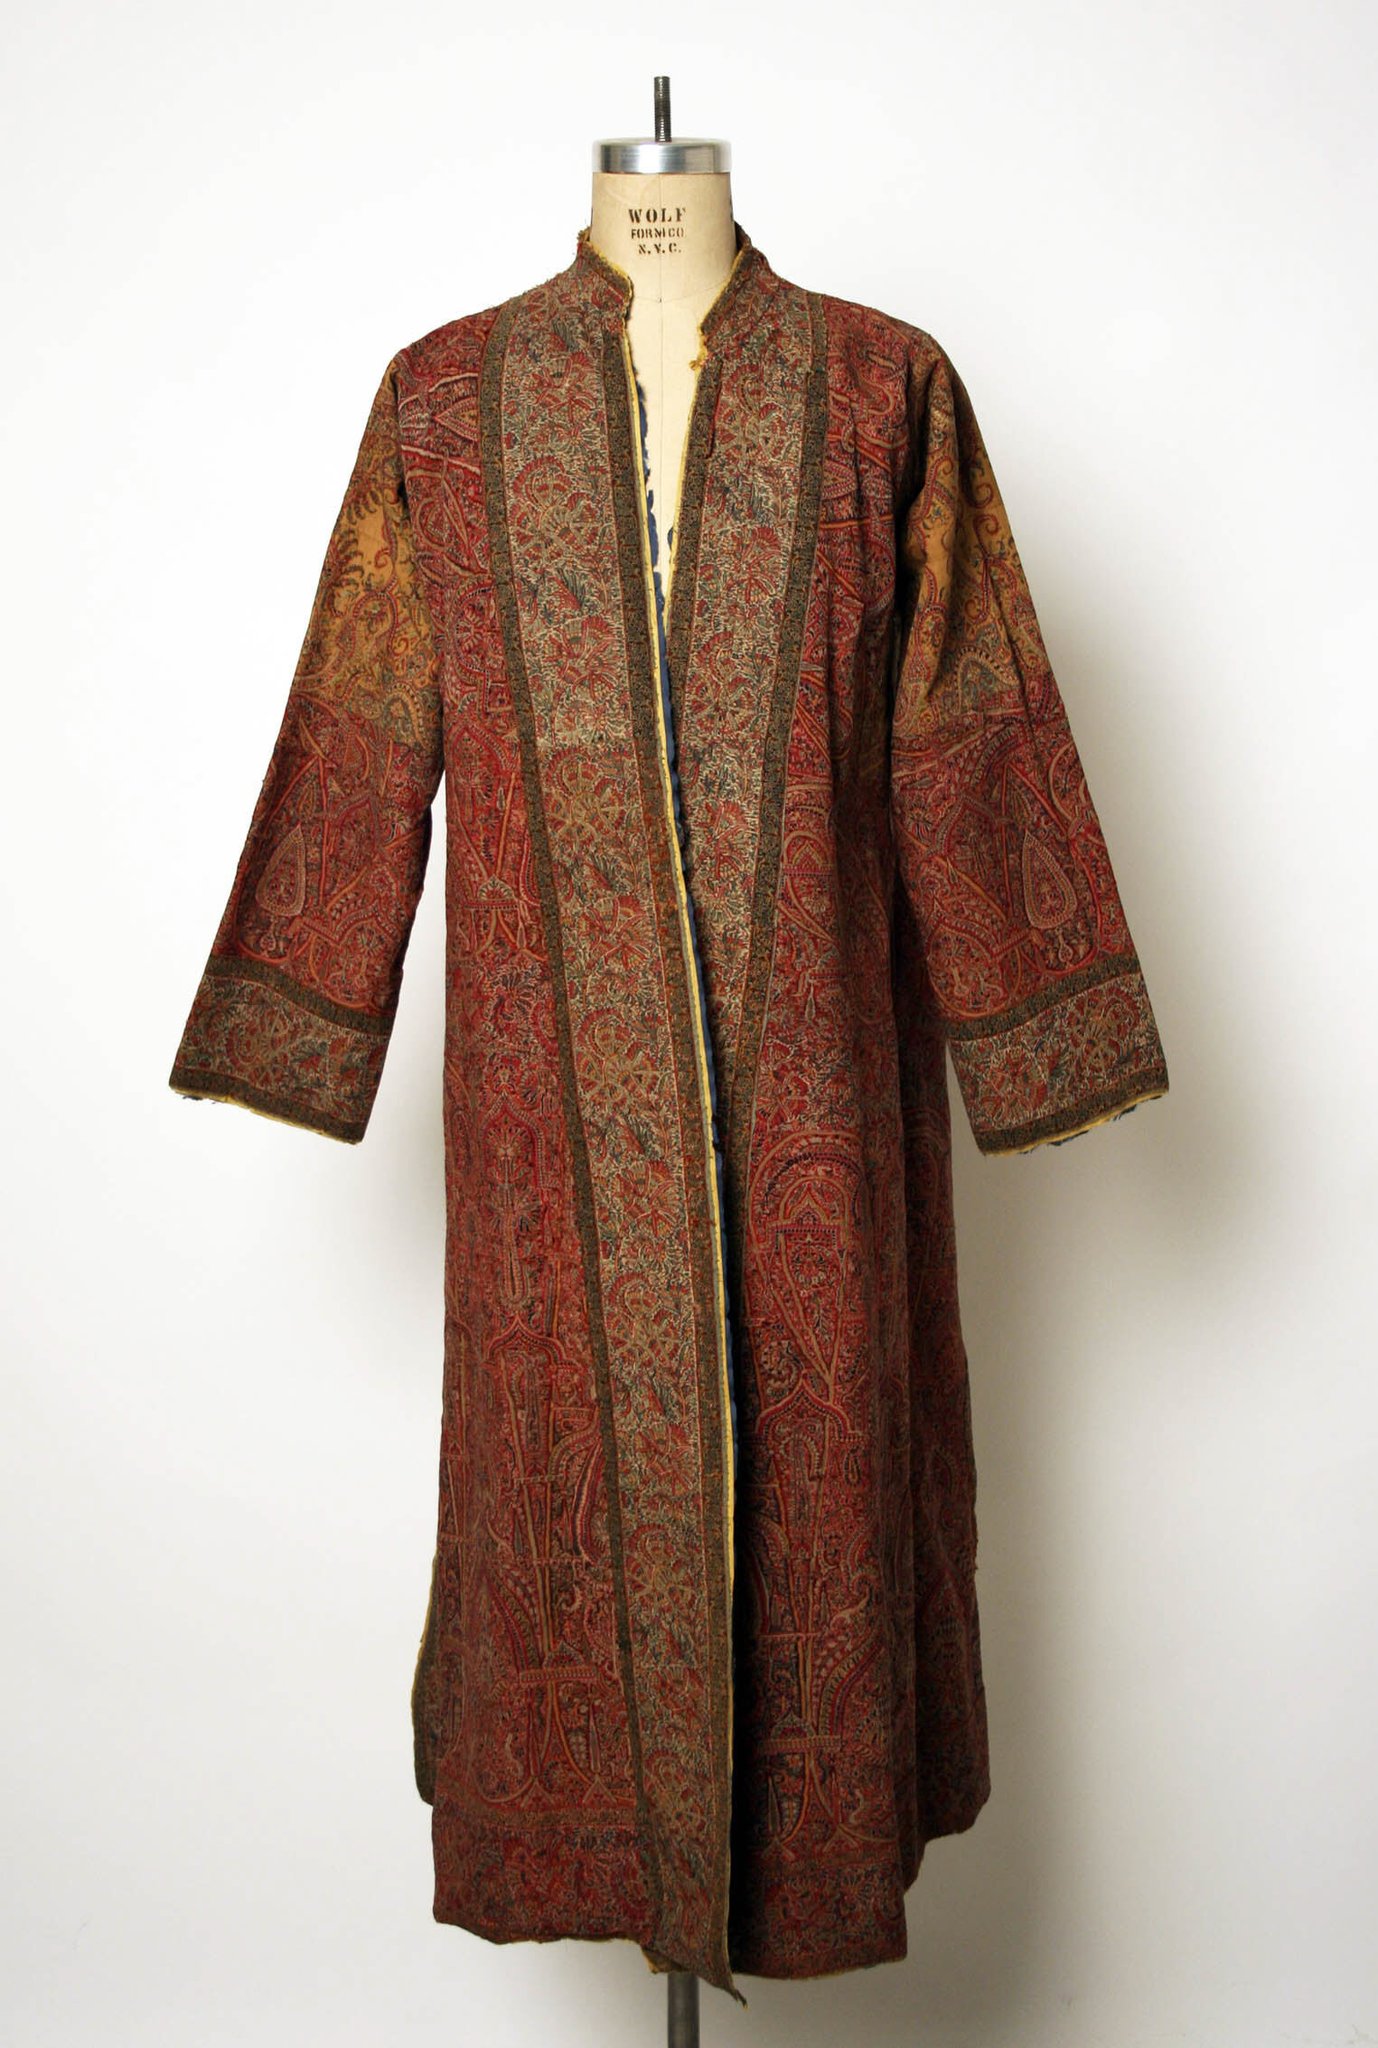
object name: coat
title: Choga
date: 1801-1900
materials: cotton, silk, wool